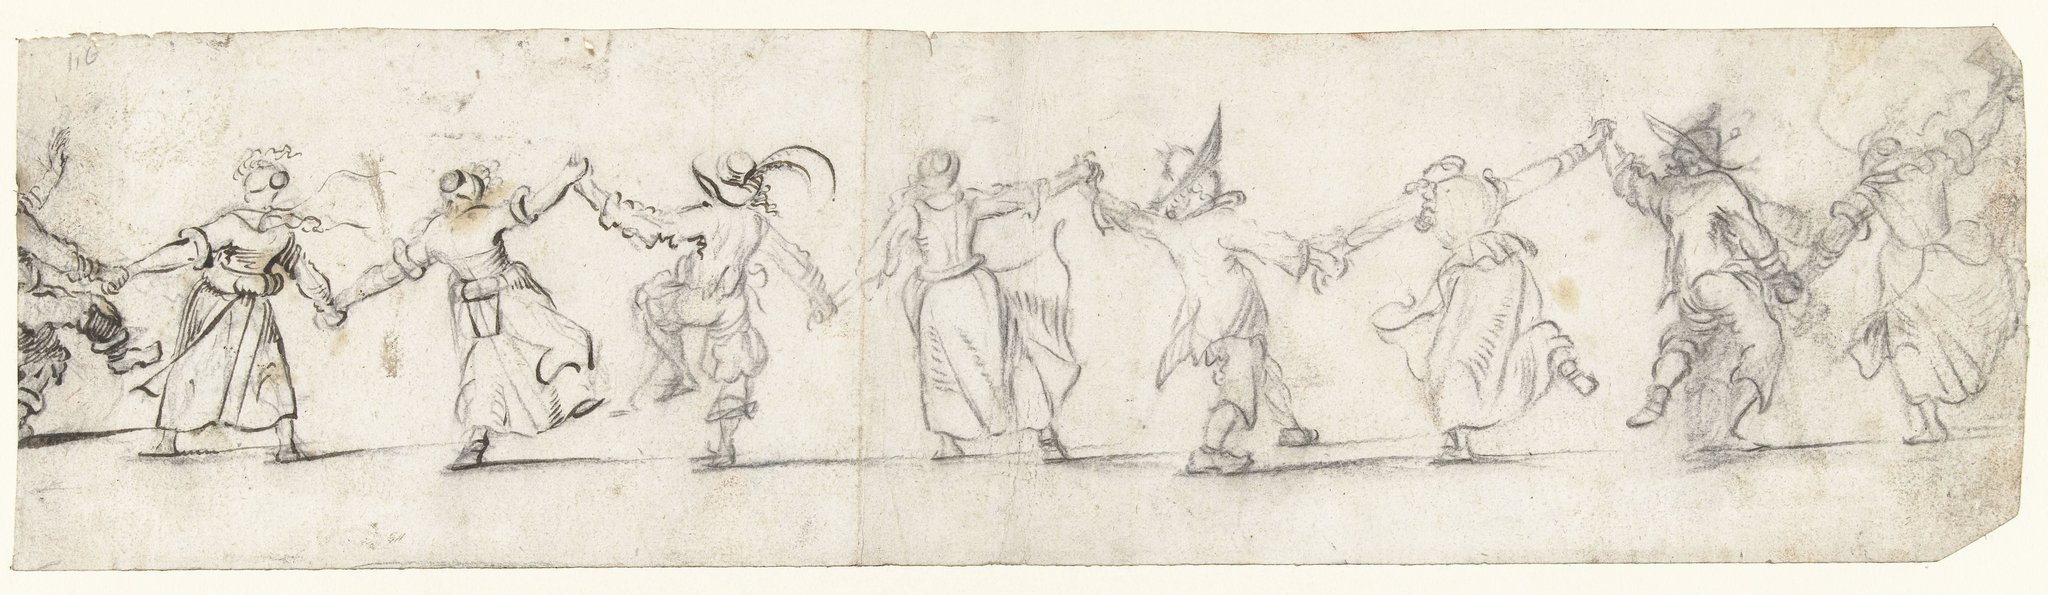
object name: drawing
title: Rij van negen dansende mannen en vrouwen, op de rug gezien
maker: harmen ter borch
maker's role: draughtsman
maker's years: 1638-1677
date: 1648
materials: chalk, ink, paper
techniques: pen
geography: zwolle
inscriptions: inscription: ‘Rutger’